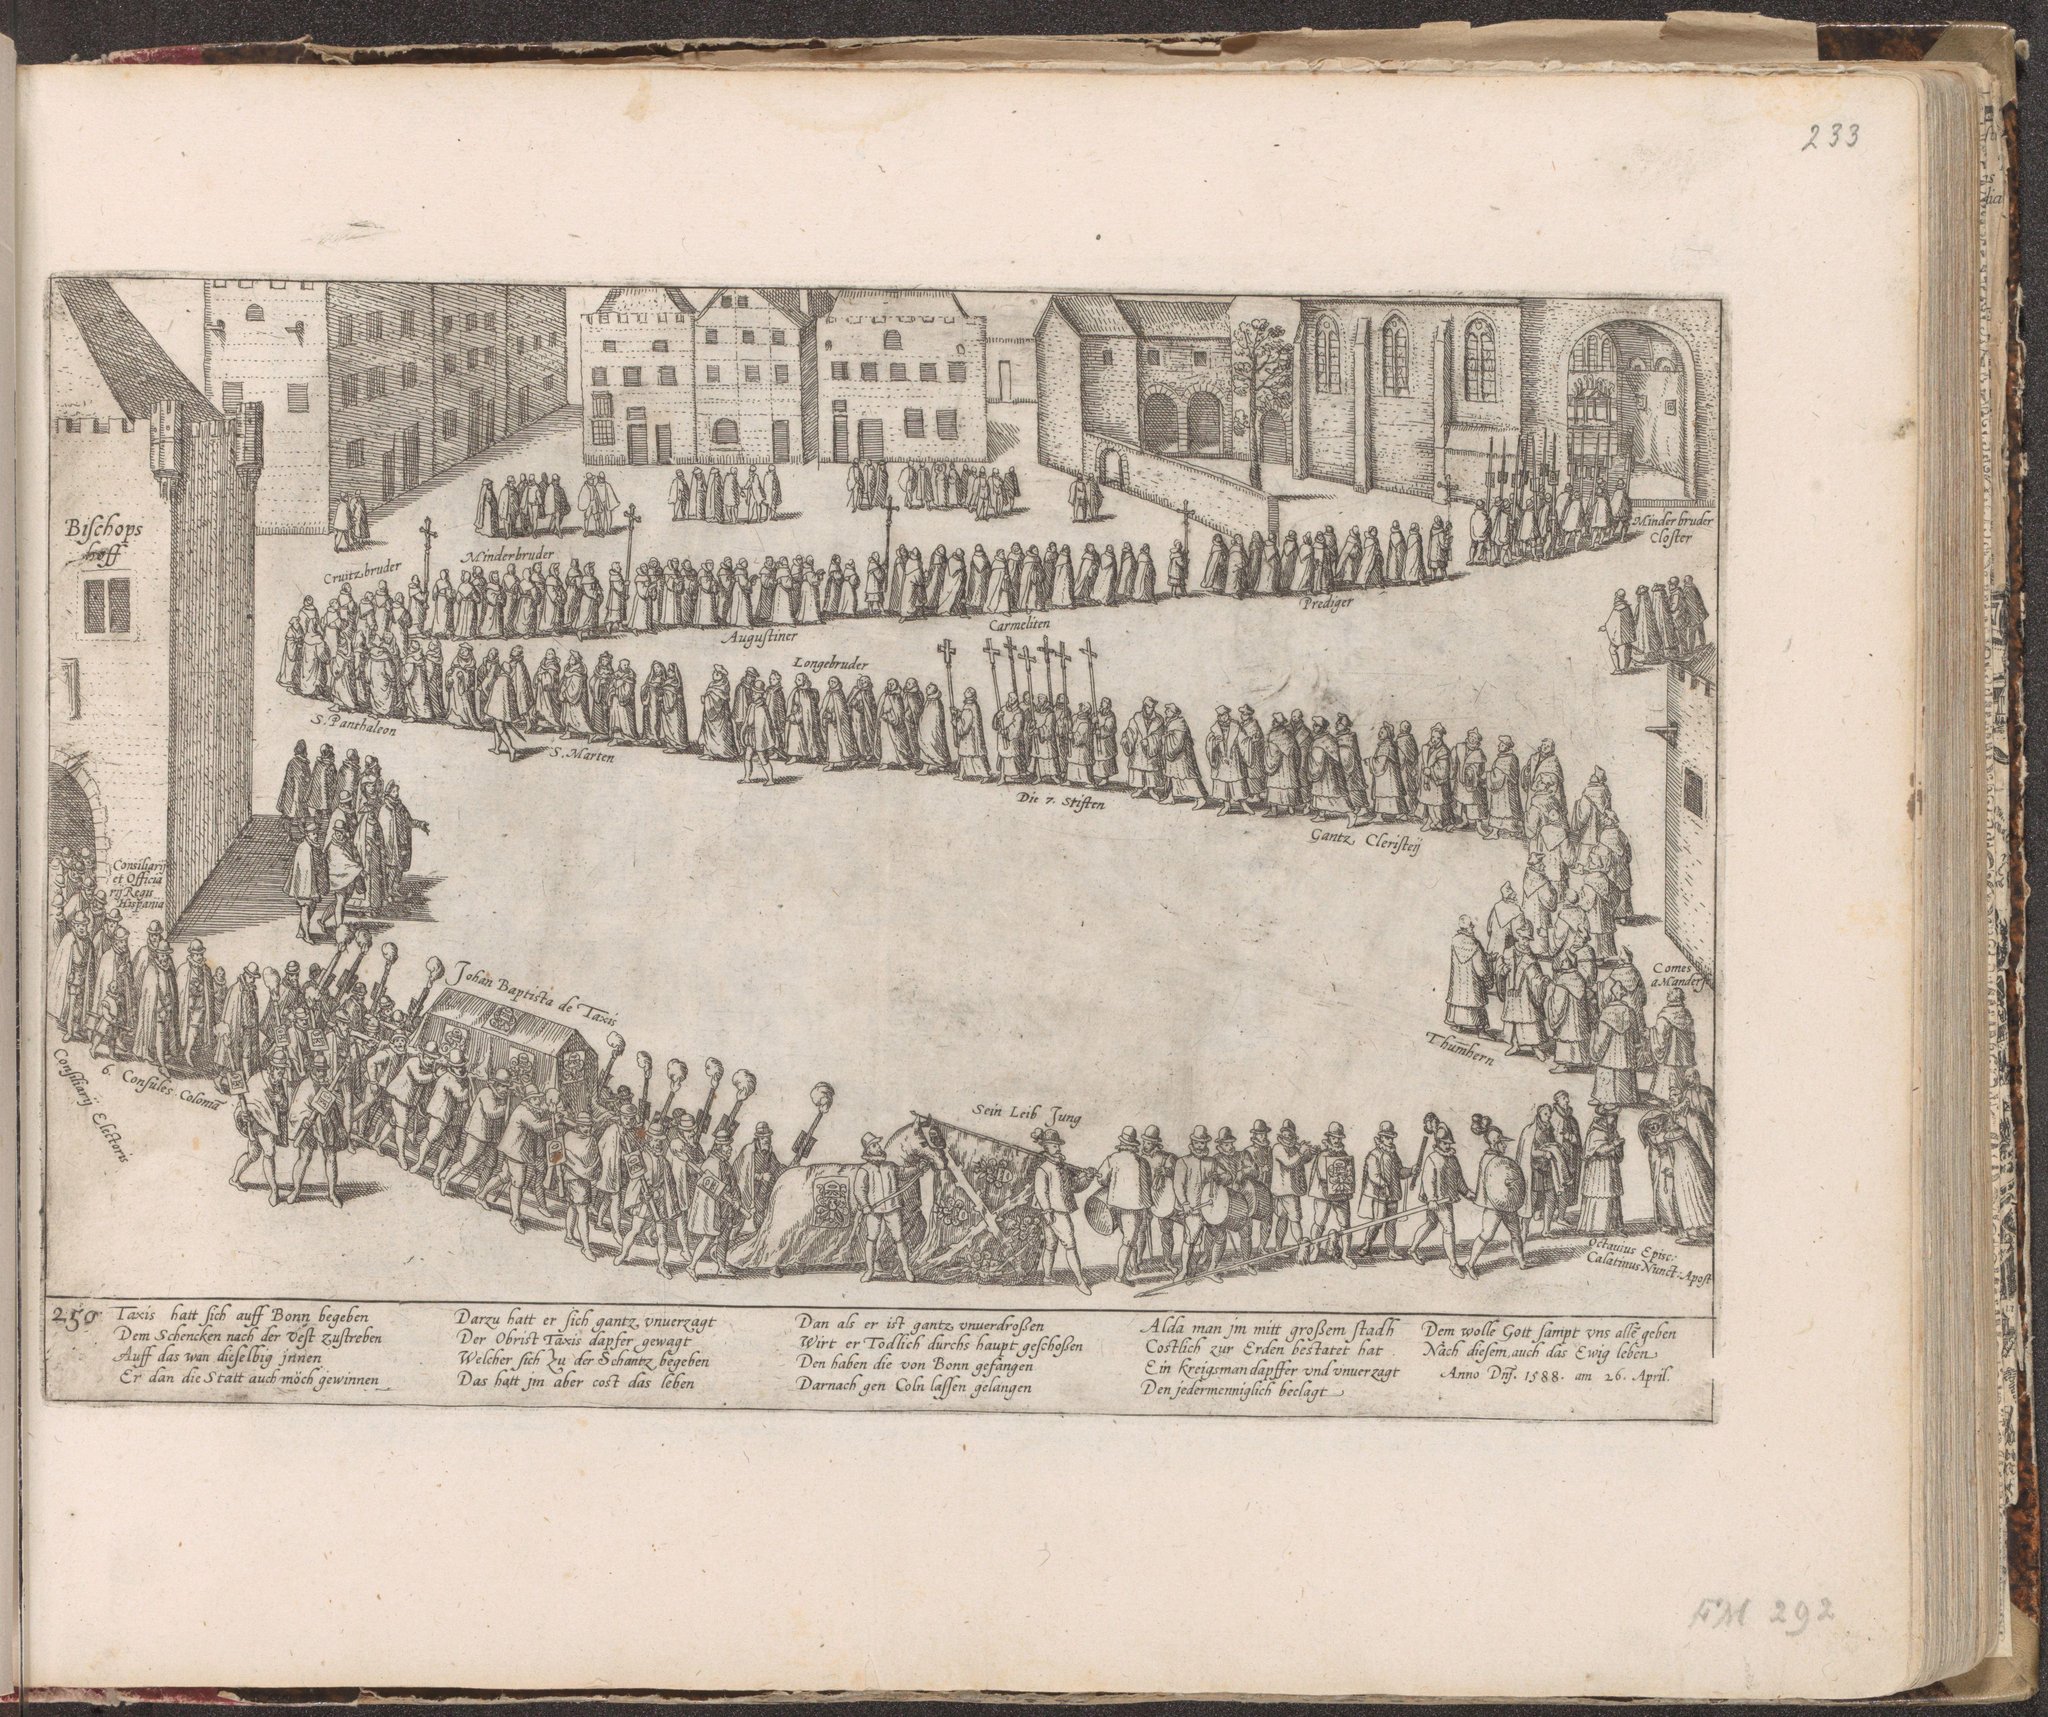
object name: album leaf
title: Serie 10: Nederlandse en Buitenlandse Gebeurtenissen, 1587-1612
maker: frans hogenberg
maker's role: print maker, publisher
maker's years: 1538-1590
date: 1588-1591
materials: paper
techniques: etching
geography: cologne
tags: cortege, funeral procession, cologne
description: Begrafenis van Johan Baptista de Taxis in Keulen, gesneuveld tijdens het beleg van Bonn, 26 april 1588. Lange begrafenisstoet slingert vanuit het Bisschopshof naar de Minderbroedersklooster. Met onderschrift van 19 regels in het Duits. Linksonder genummerd: 250. De prent maakt deel uit van een album.